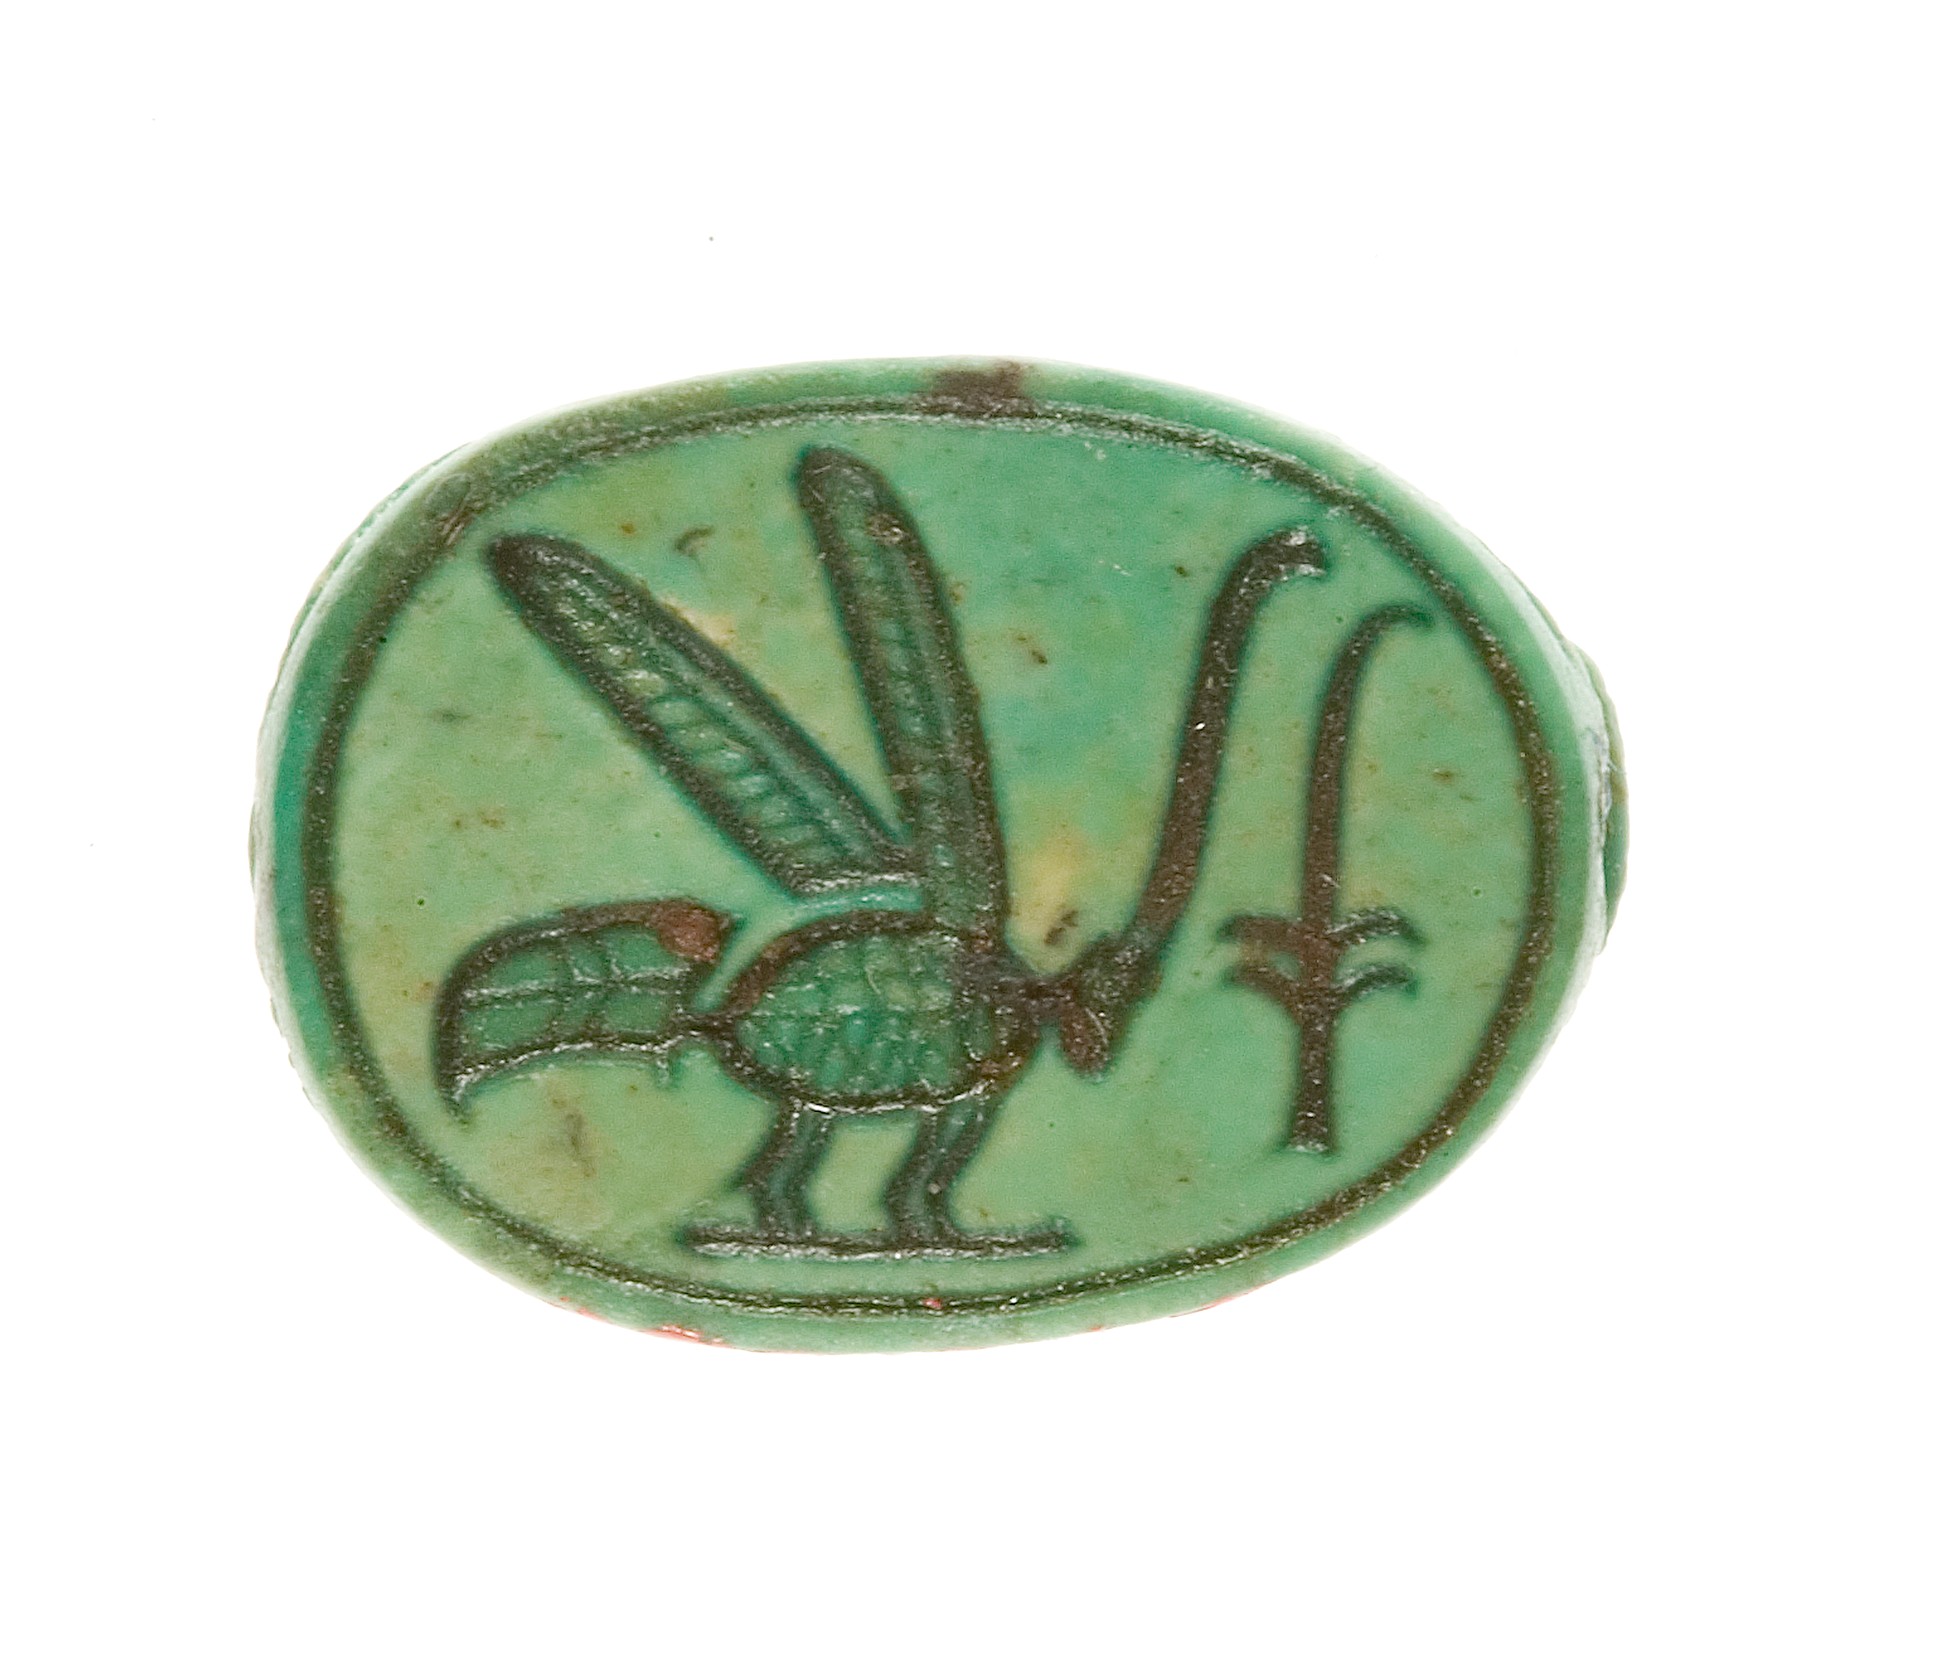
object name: scarab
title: Scarab Inscribed King of Upper and Lower Egypt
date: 1479-1458 BCE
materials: stone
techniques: glazing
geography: egypt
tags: scarabs